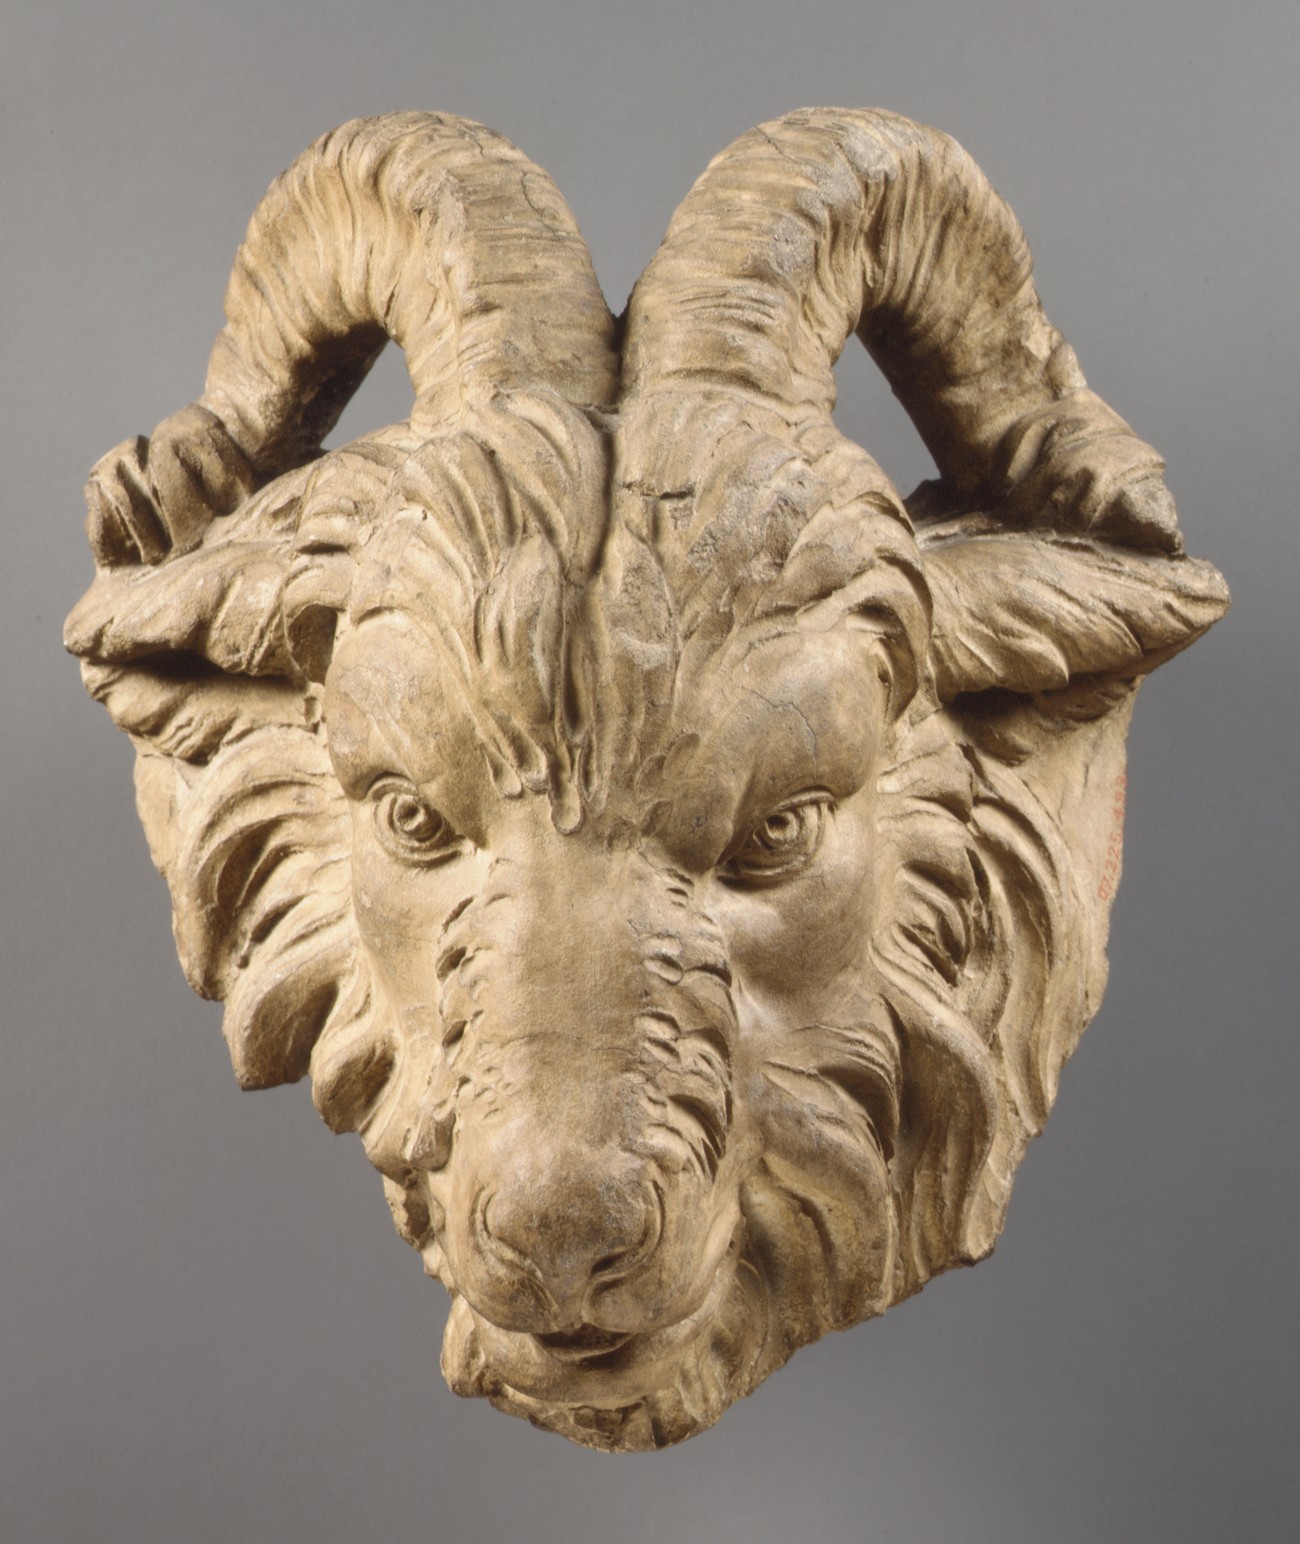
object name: sculpture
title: Goat's Head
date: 1760-1780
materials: terracotta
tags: goats